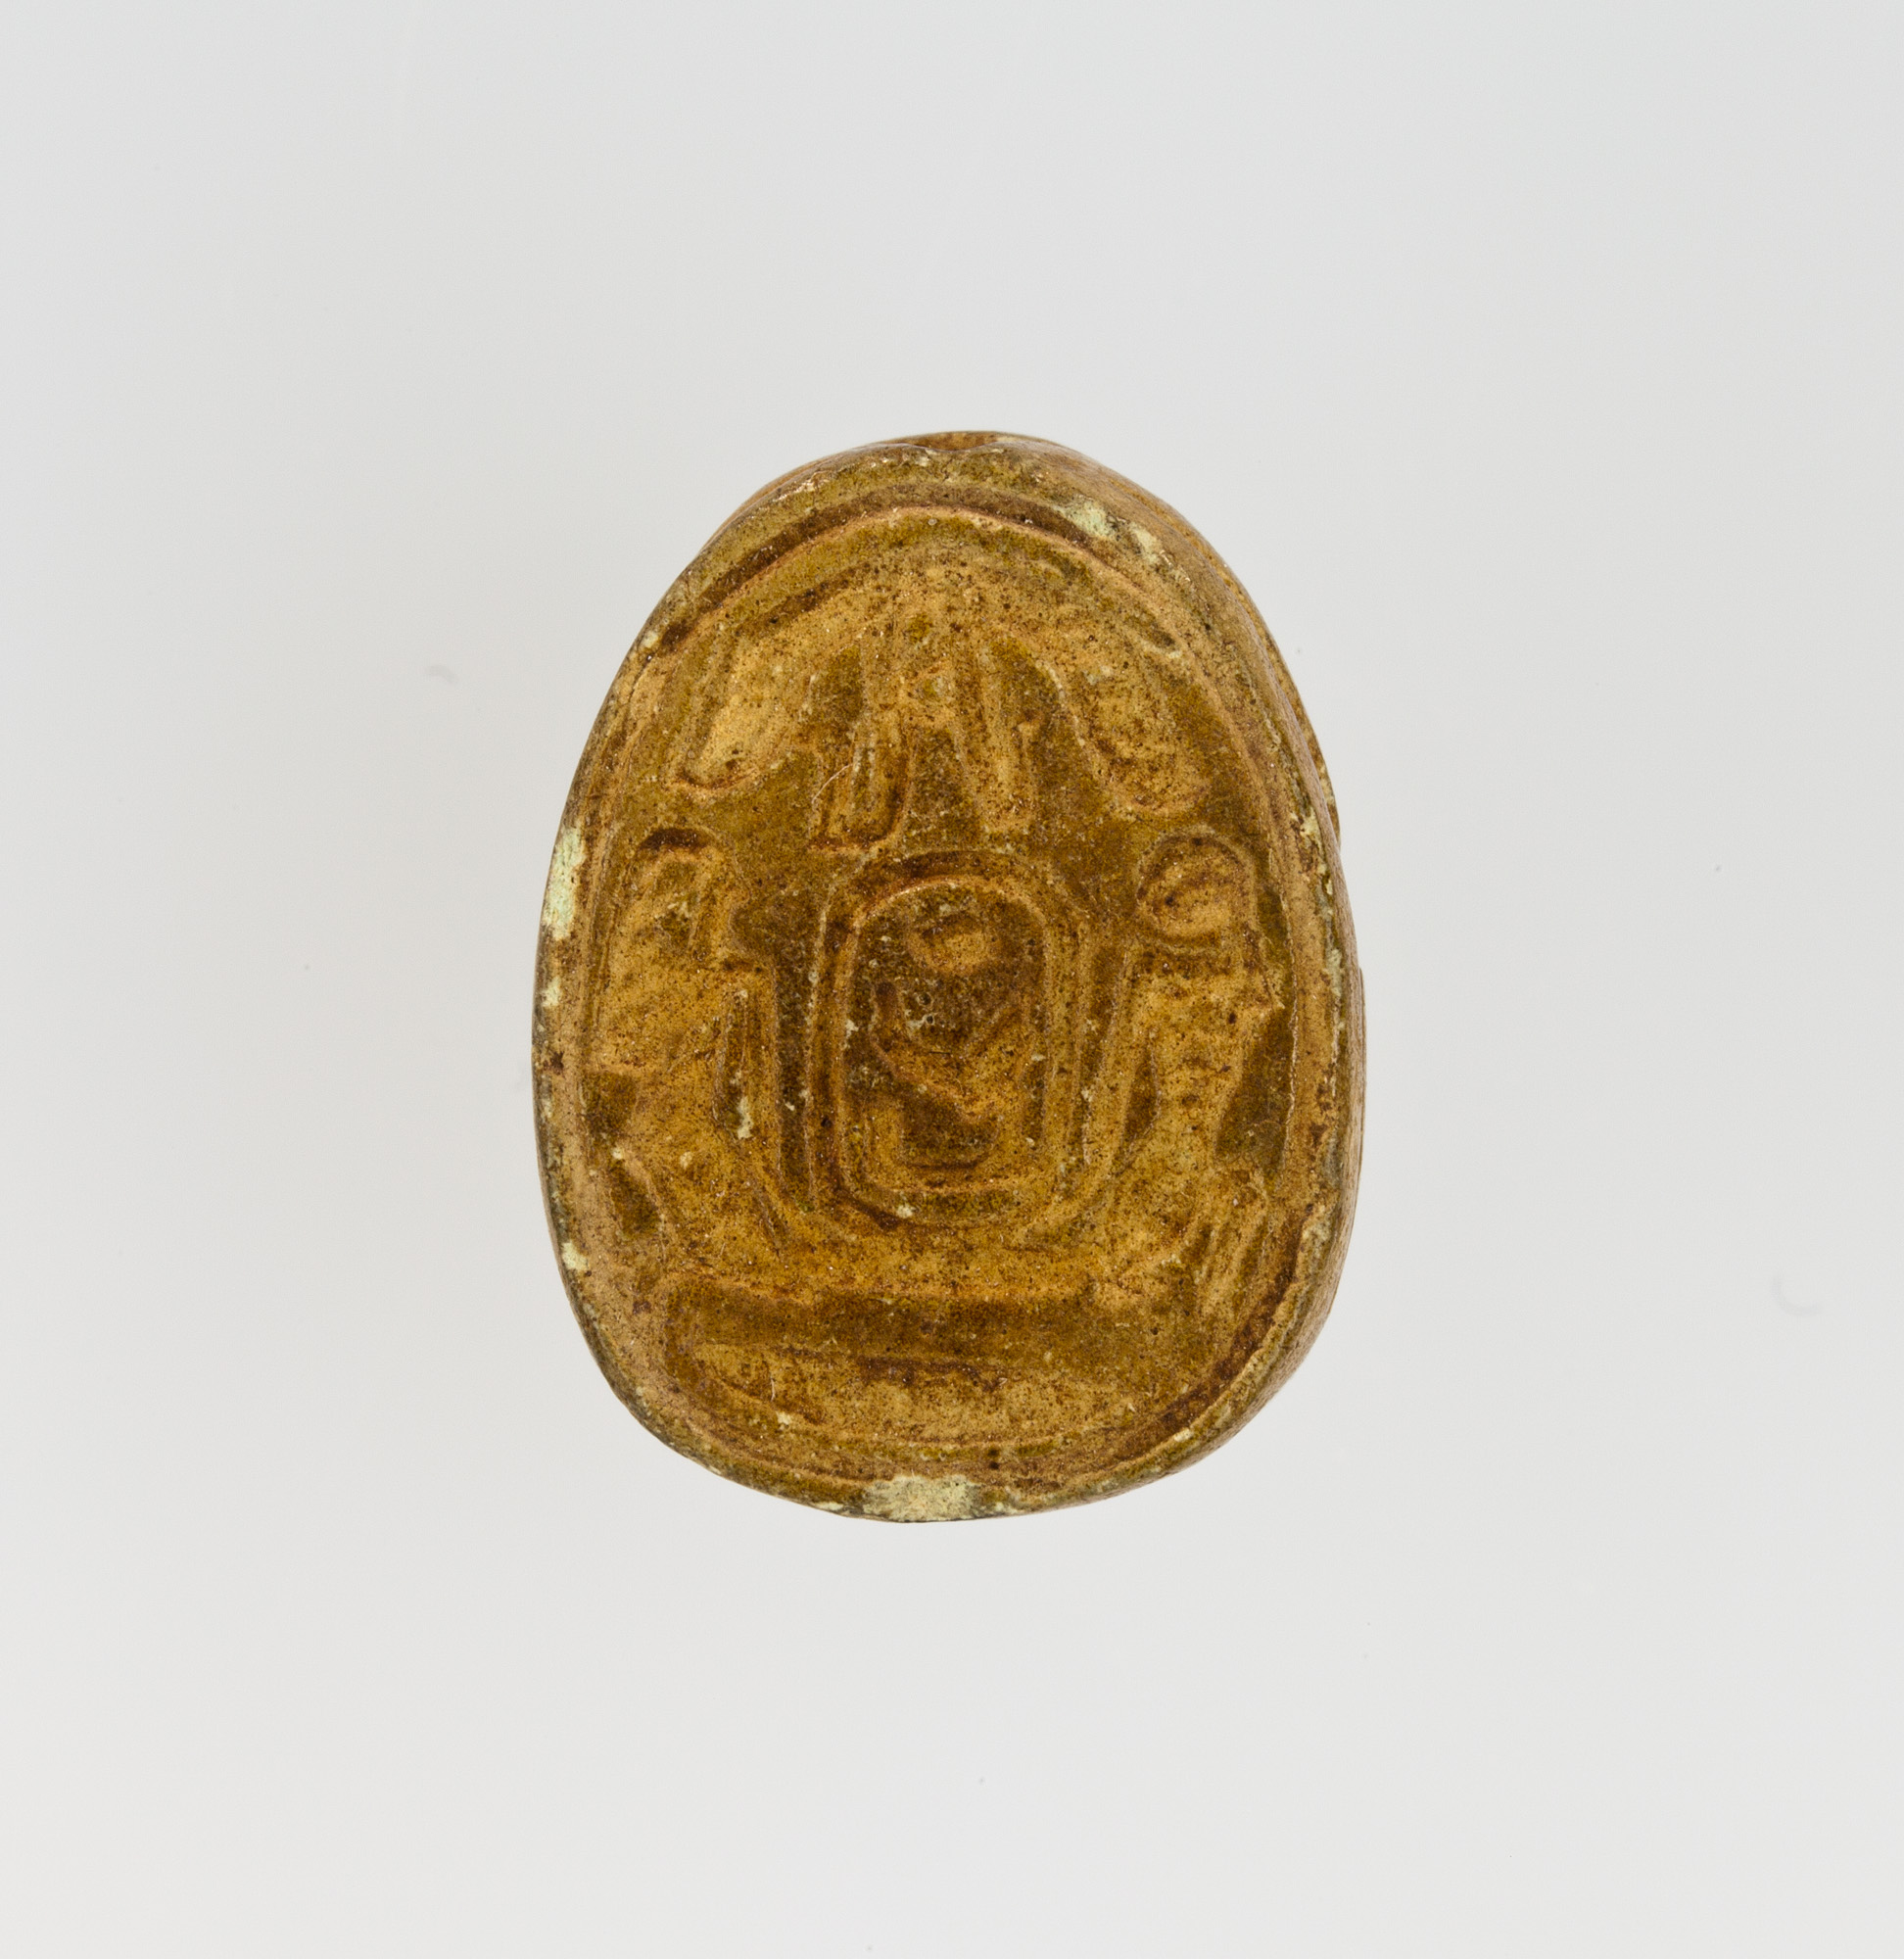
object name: scarab, amenhotep i, djeserkare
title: Scarab Inscribed with the Throne Name of Amenhotep I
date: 1525-1504 BCE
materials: stone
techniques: glazing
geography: egypt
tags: scarabs